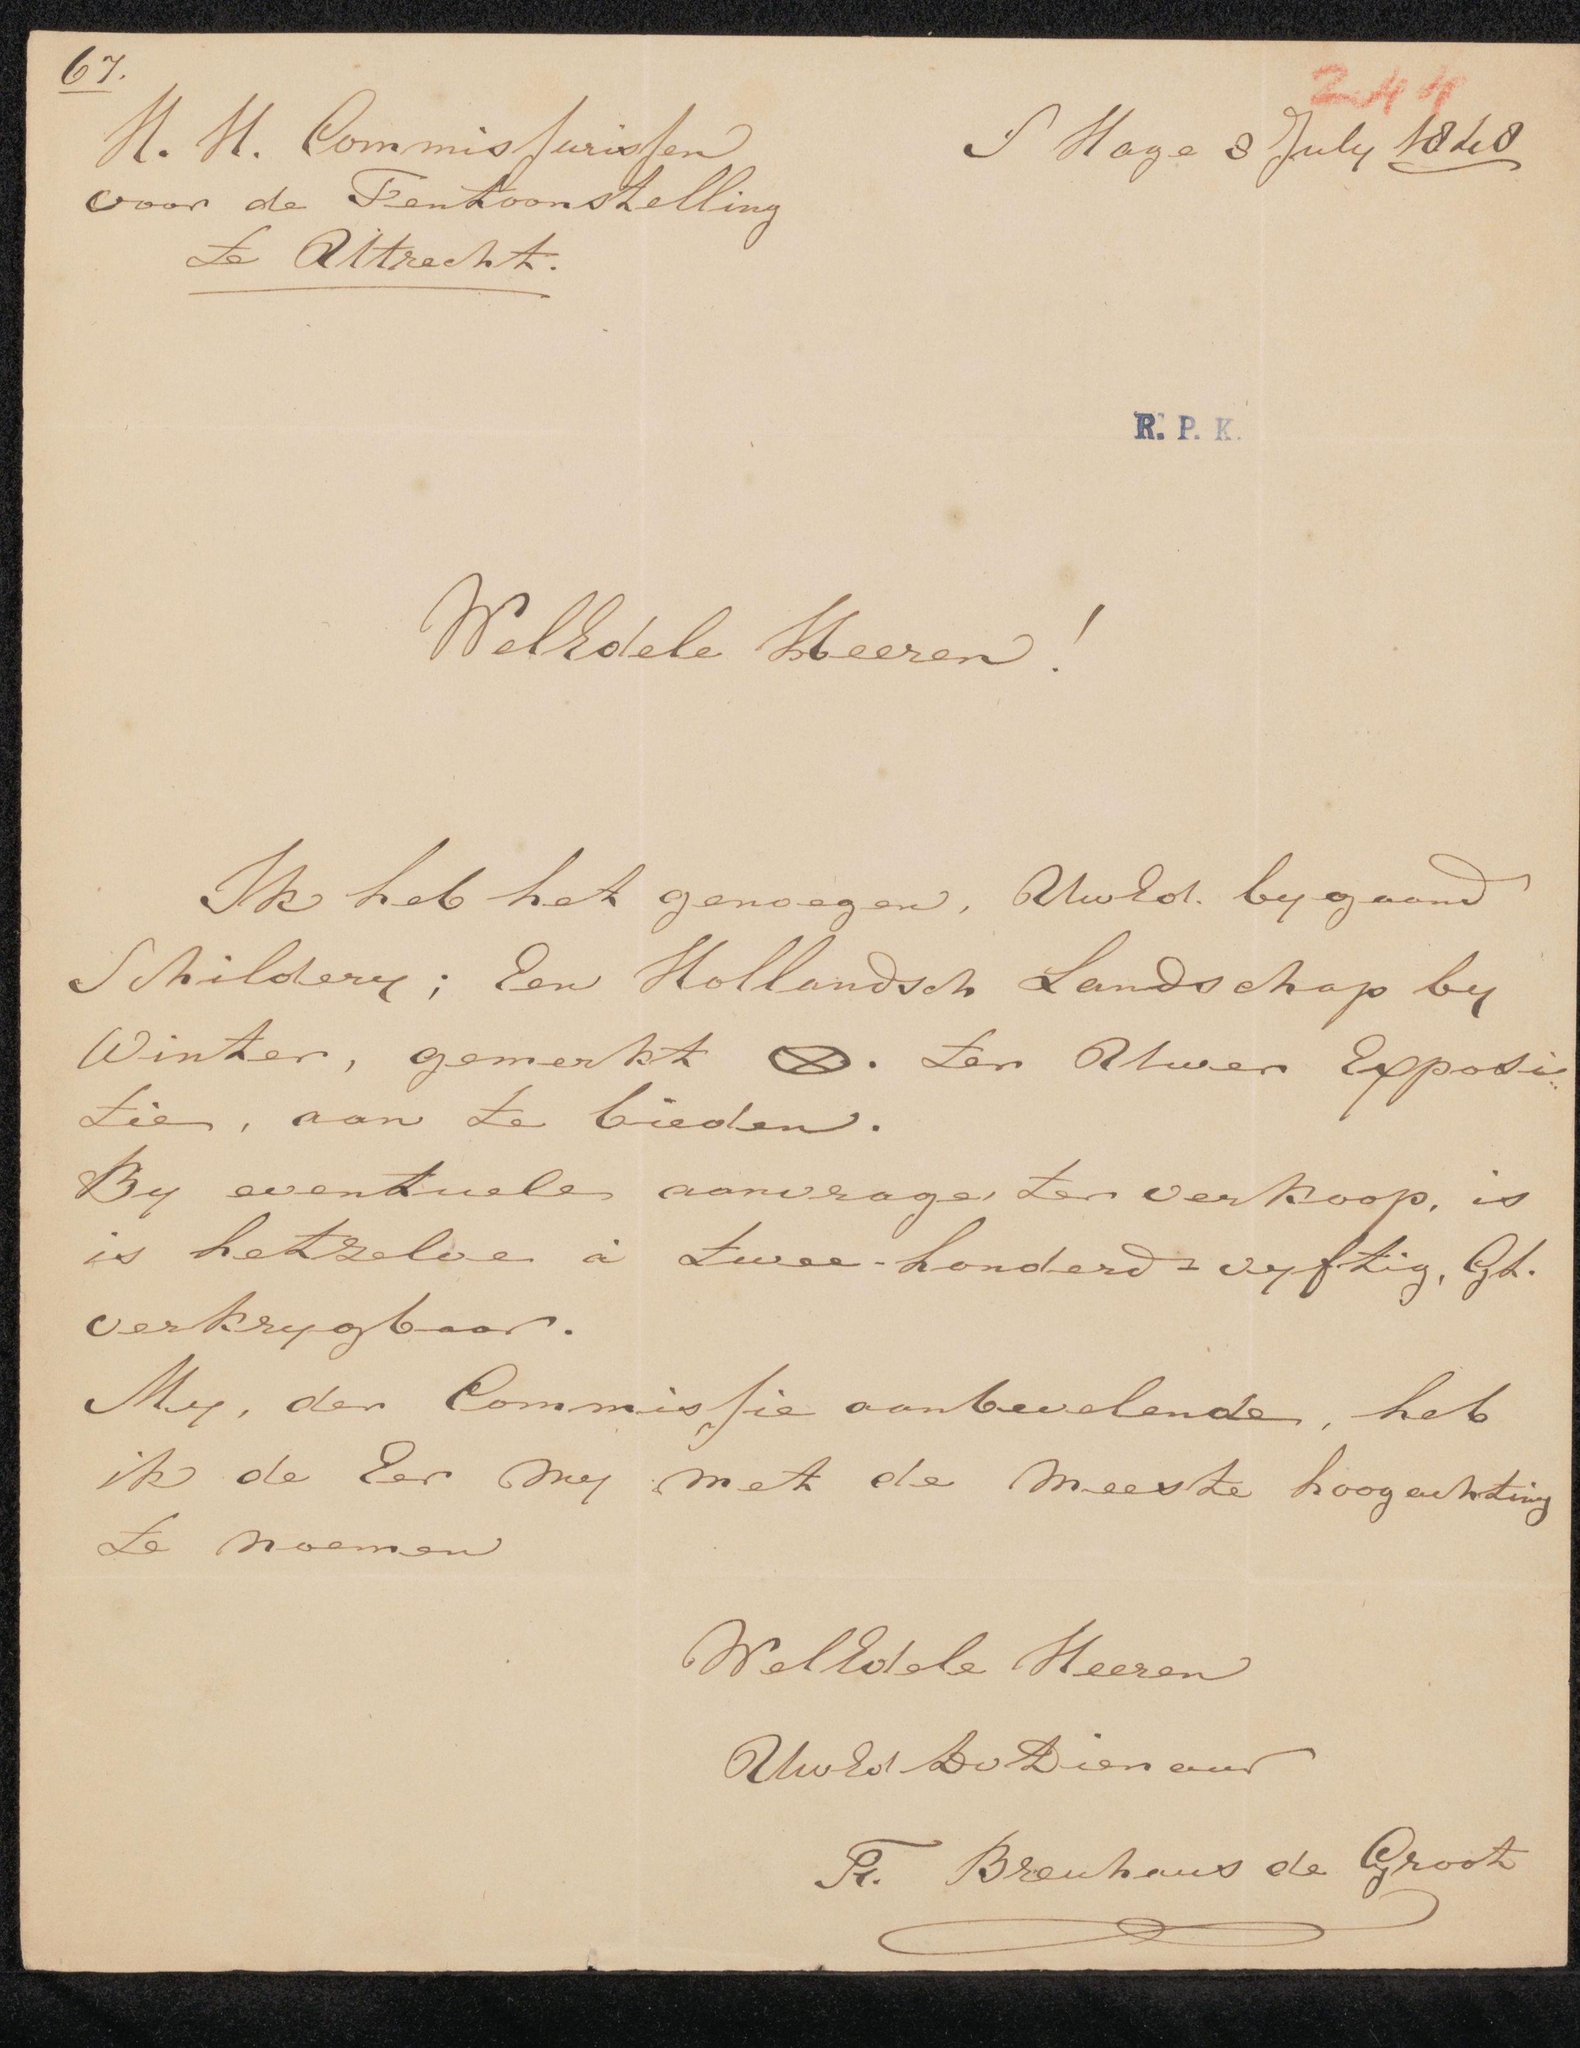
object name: letter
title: Brief aan de commissie van de Tentoonstelling van Levende Meesters in Utrecht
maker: frans arnold breuhaus de groot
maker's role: draughtsman, print maker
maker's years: 1824-1872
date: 1848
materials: ink, paper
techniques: pen, writing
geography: the hague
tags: painting (including book-illumination, miniature-painting), exhibition ~ art, art collecting, money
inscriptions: watermark, collector's mark: Lugt 2233